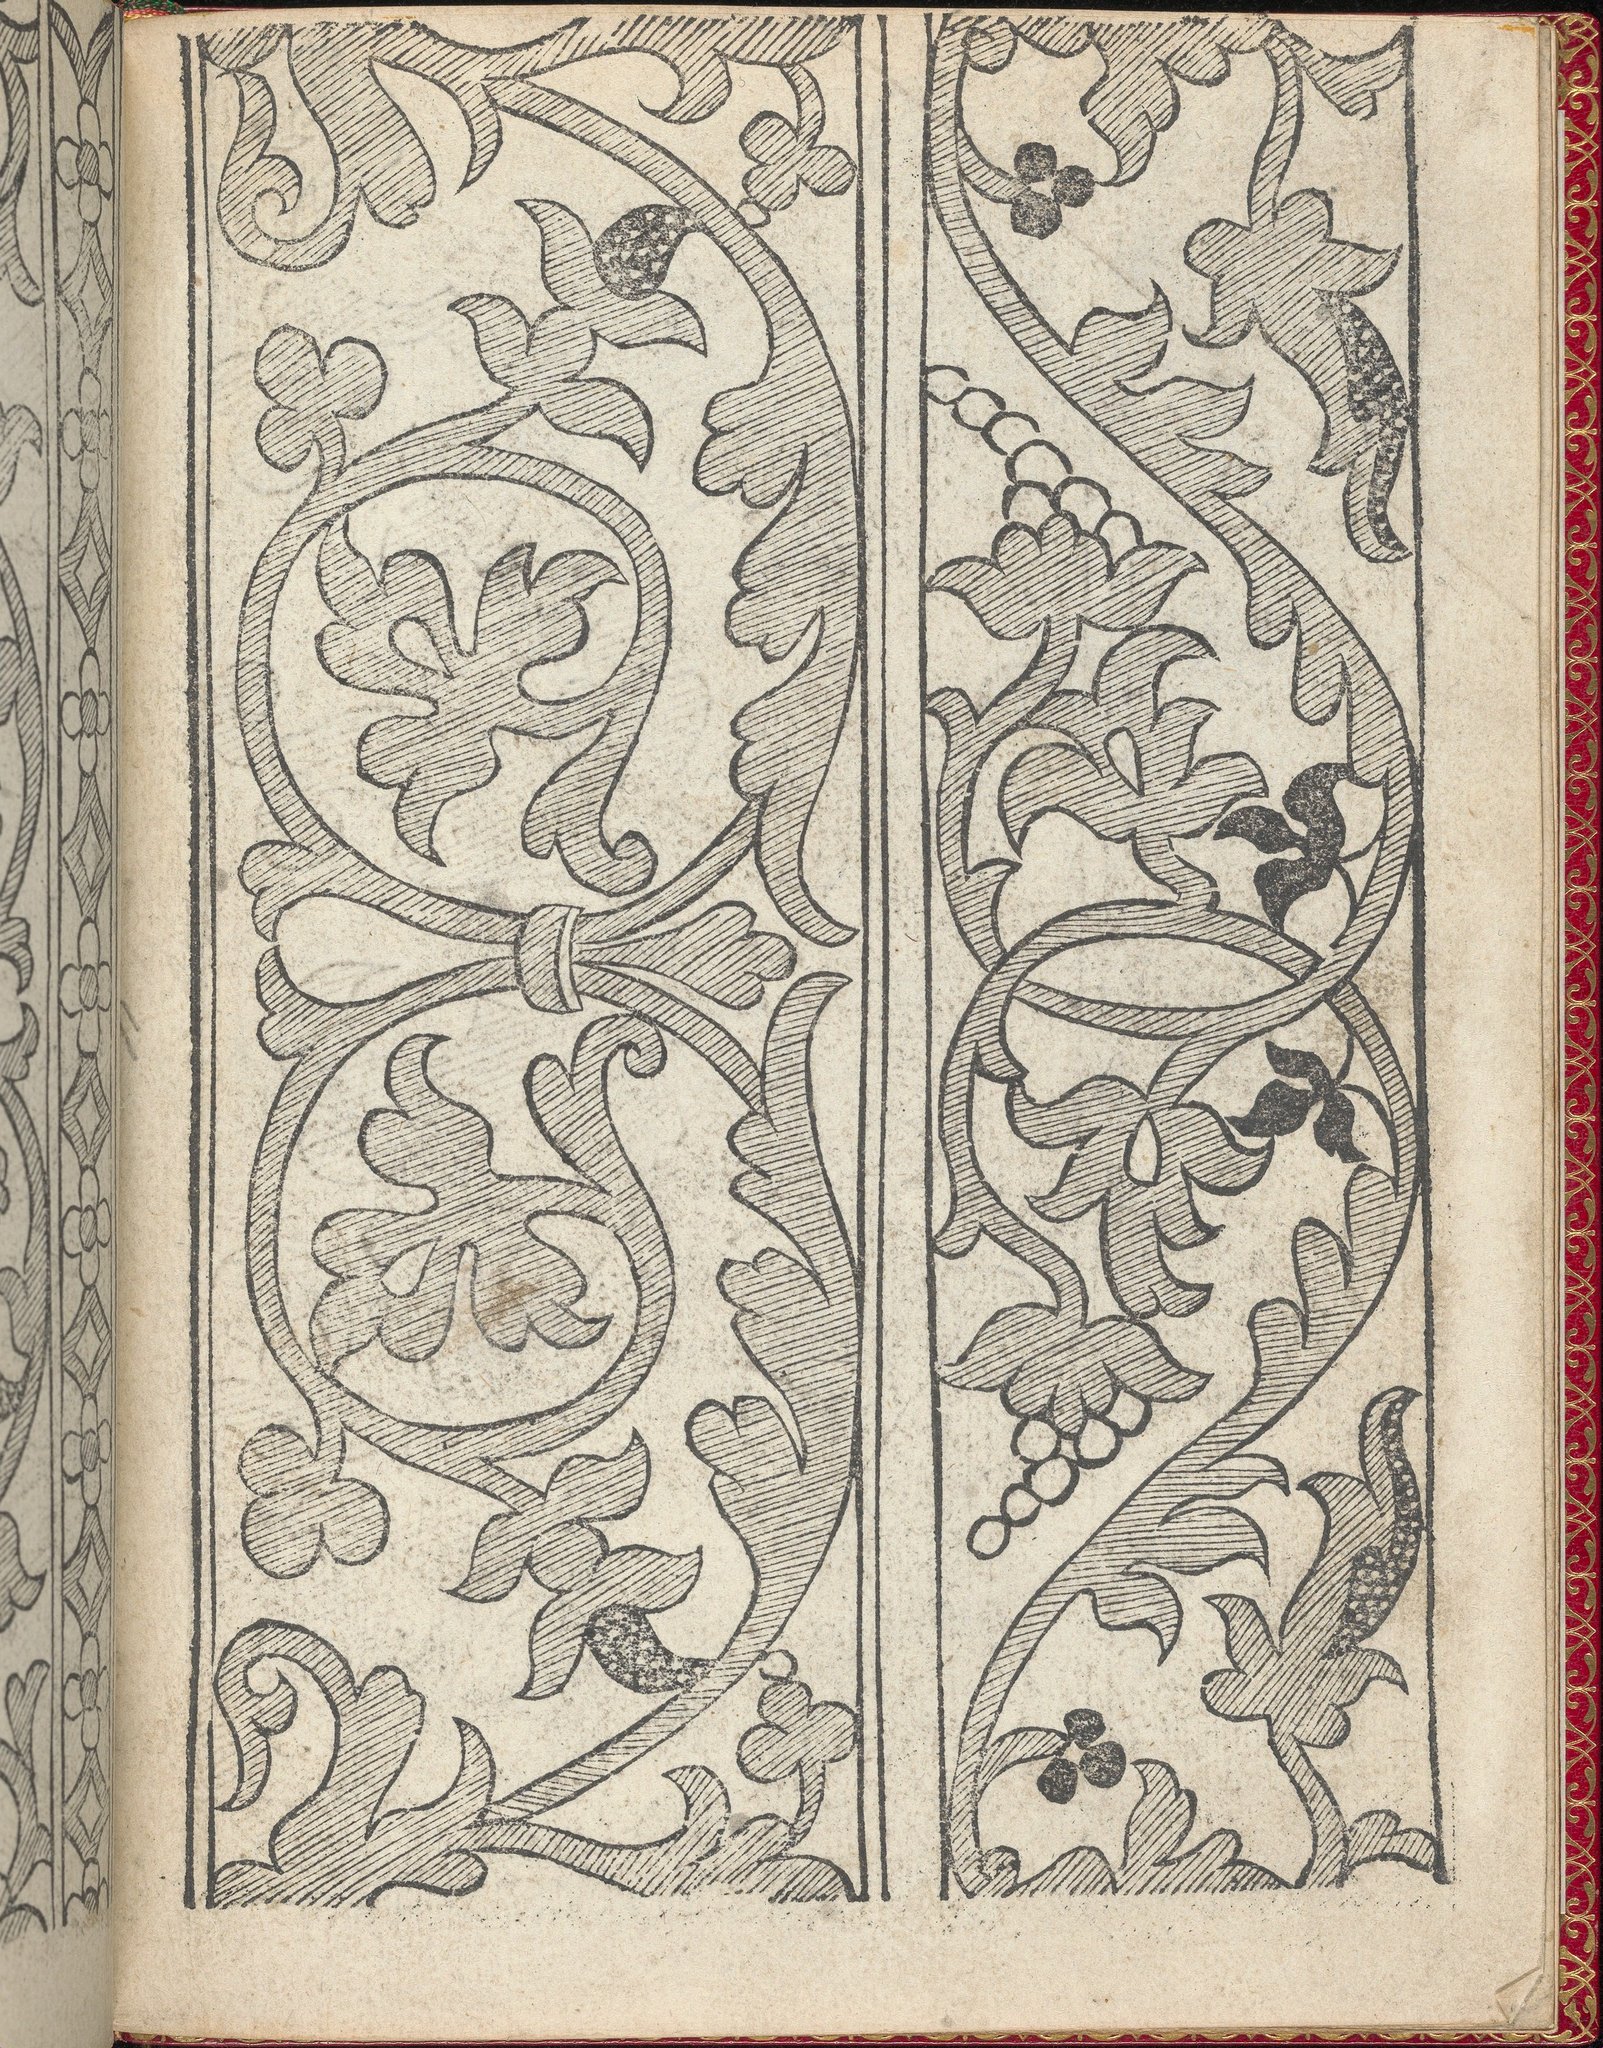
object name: book print ornament architecture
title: Il Monte. Opera Nova di Recami, page 6 (verso)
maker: giovanni antonio bindoni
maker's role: designer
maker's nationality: italian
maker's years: 1500-1650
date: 1557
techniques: woodcut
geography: italy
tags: ornament